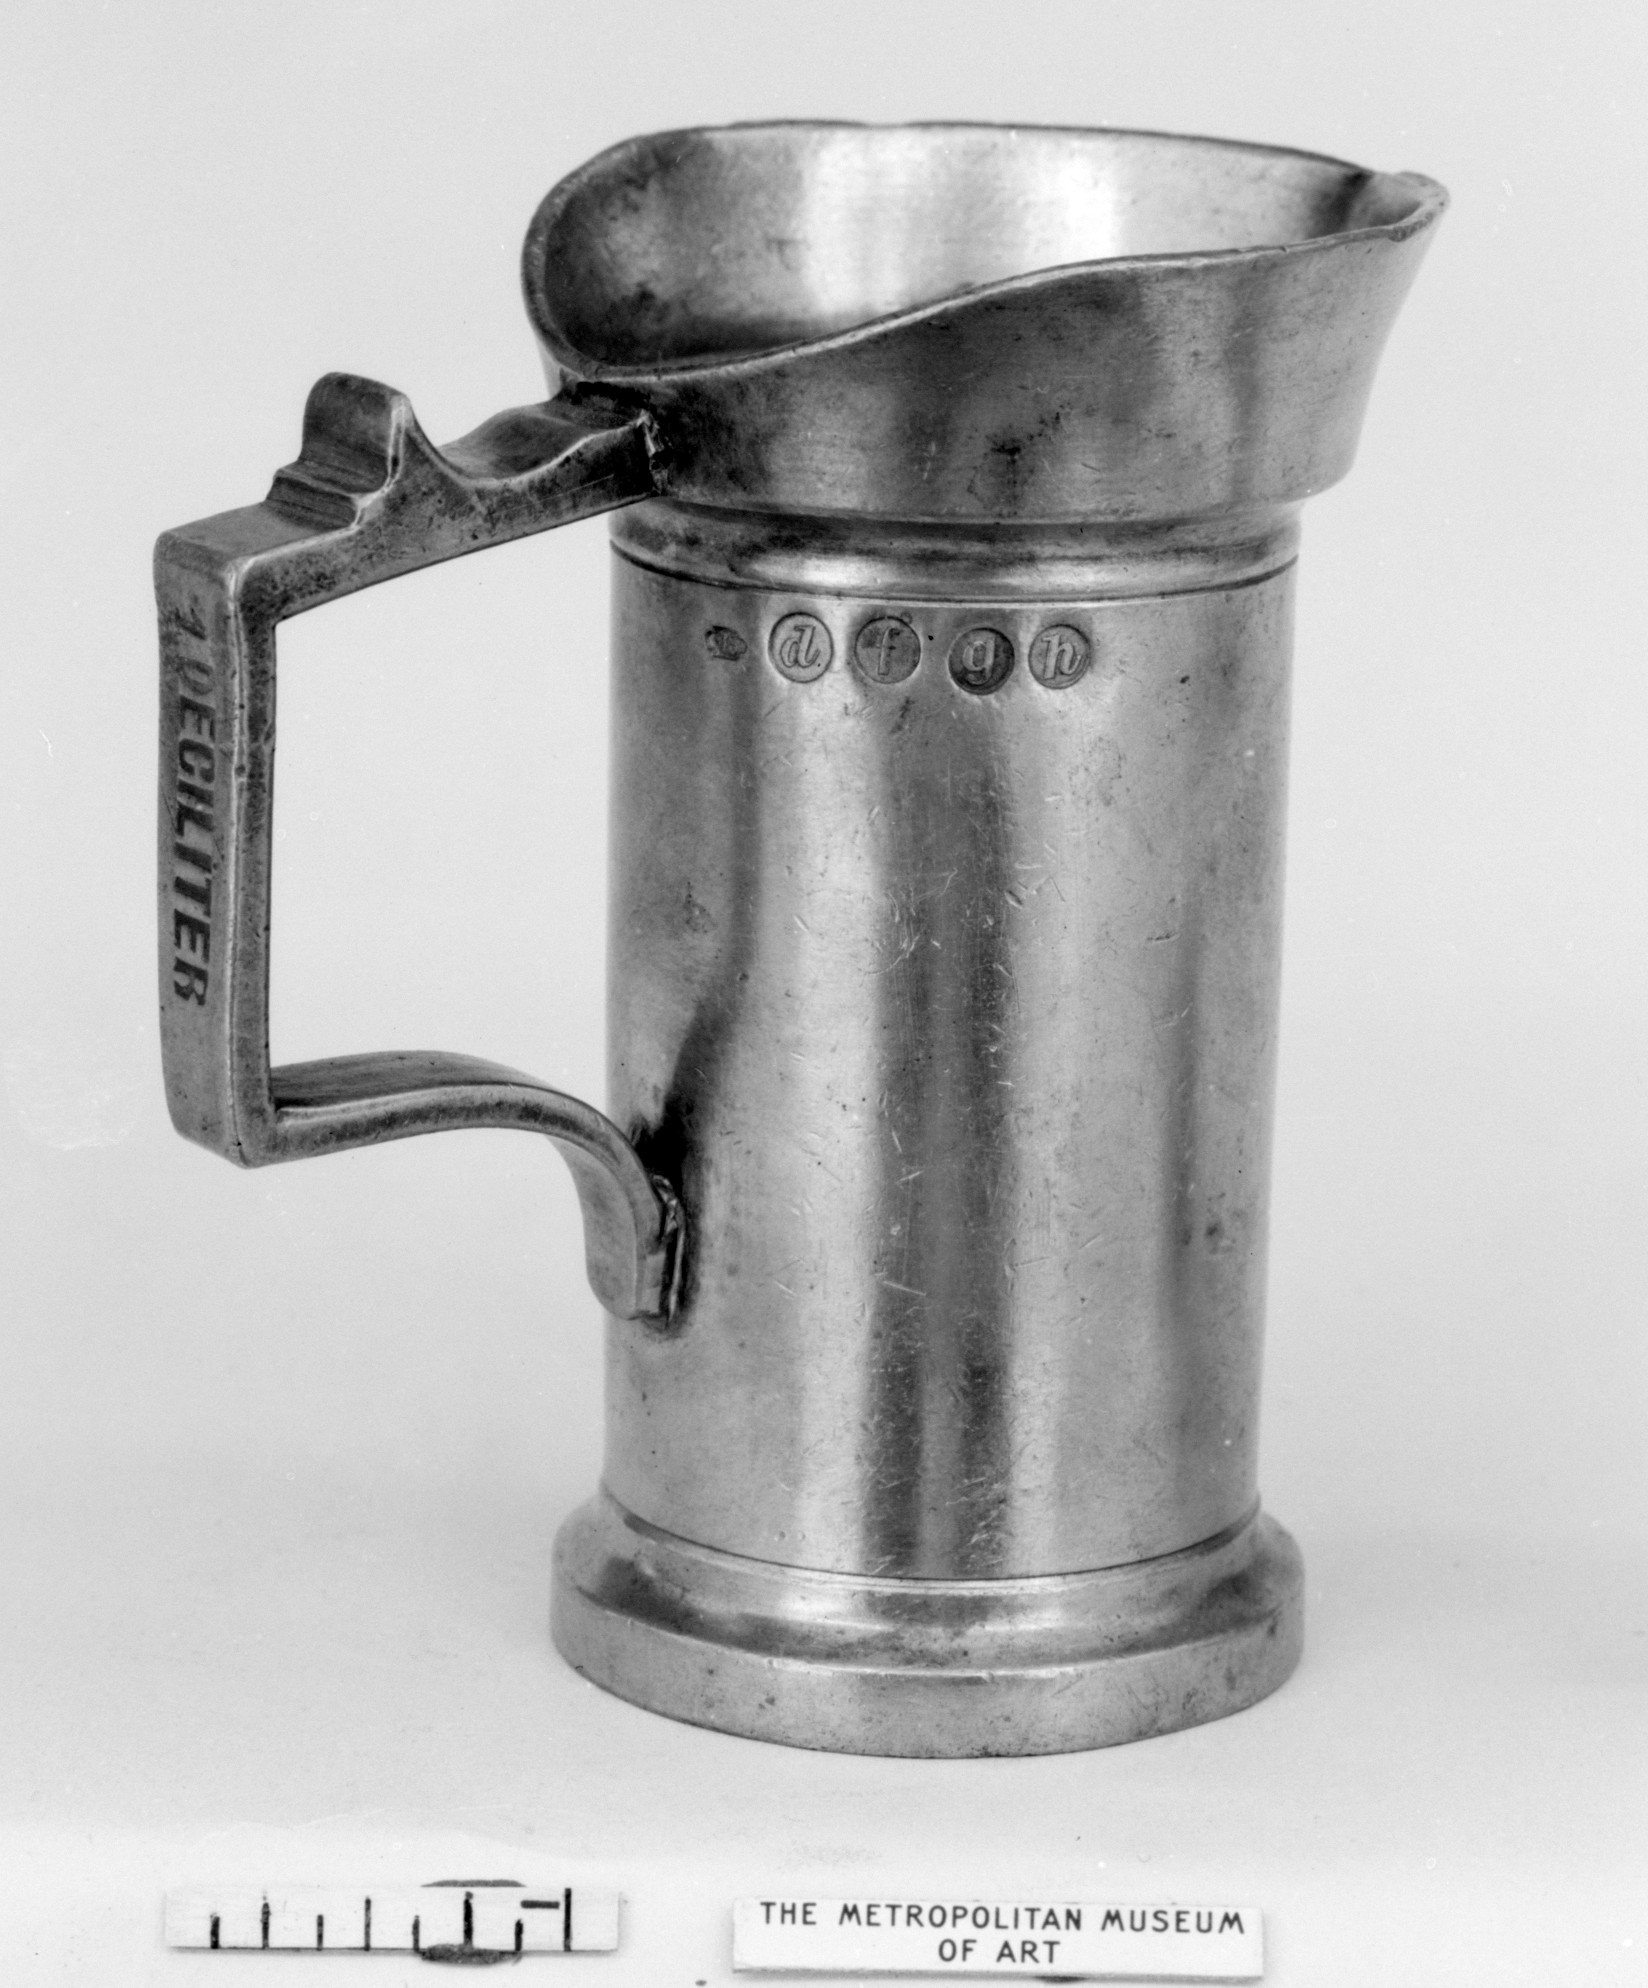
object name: measure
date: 1767-1833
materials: pewter